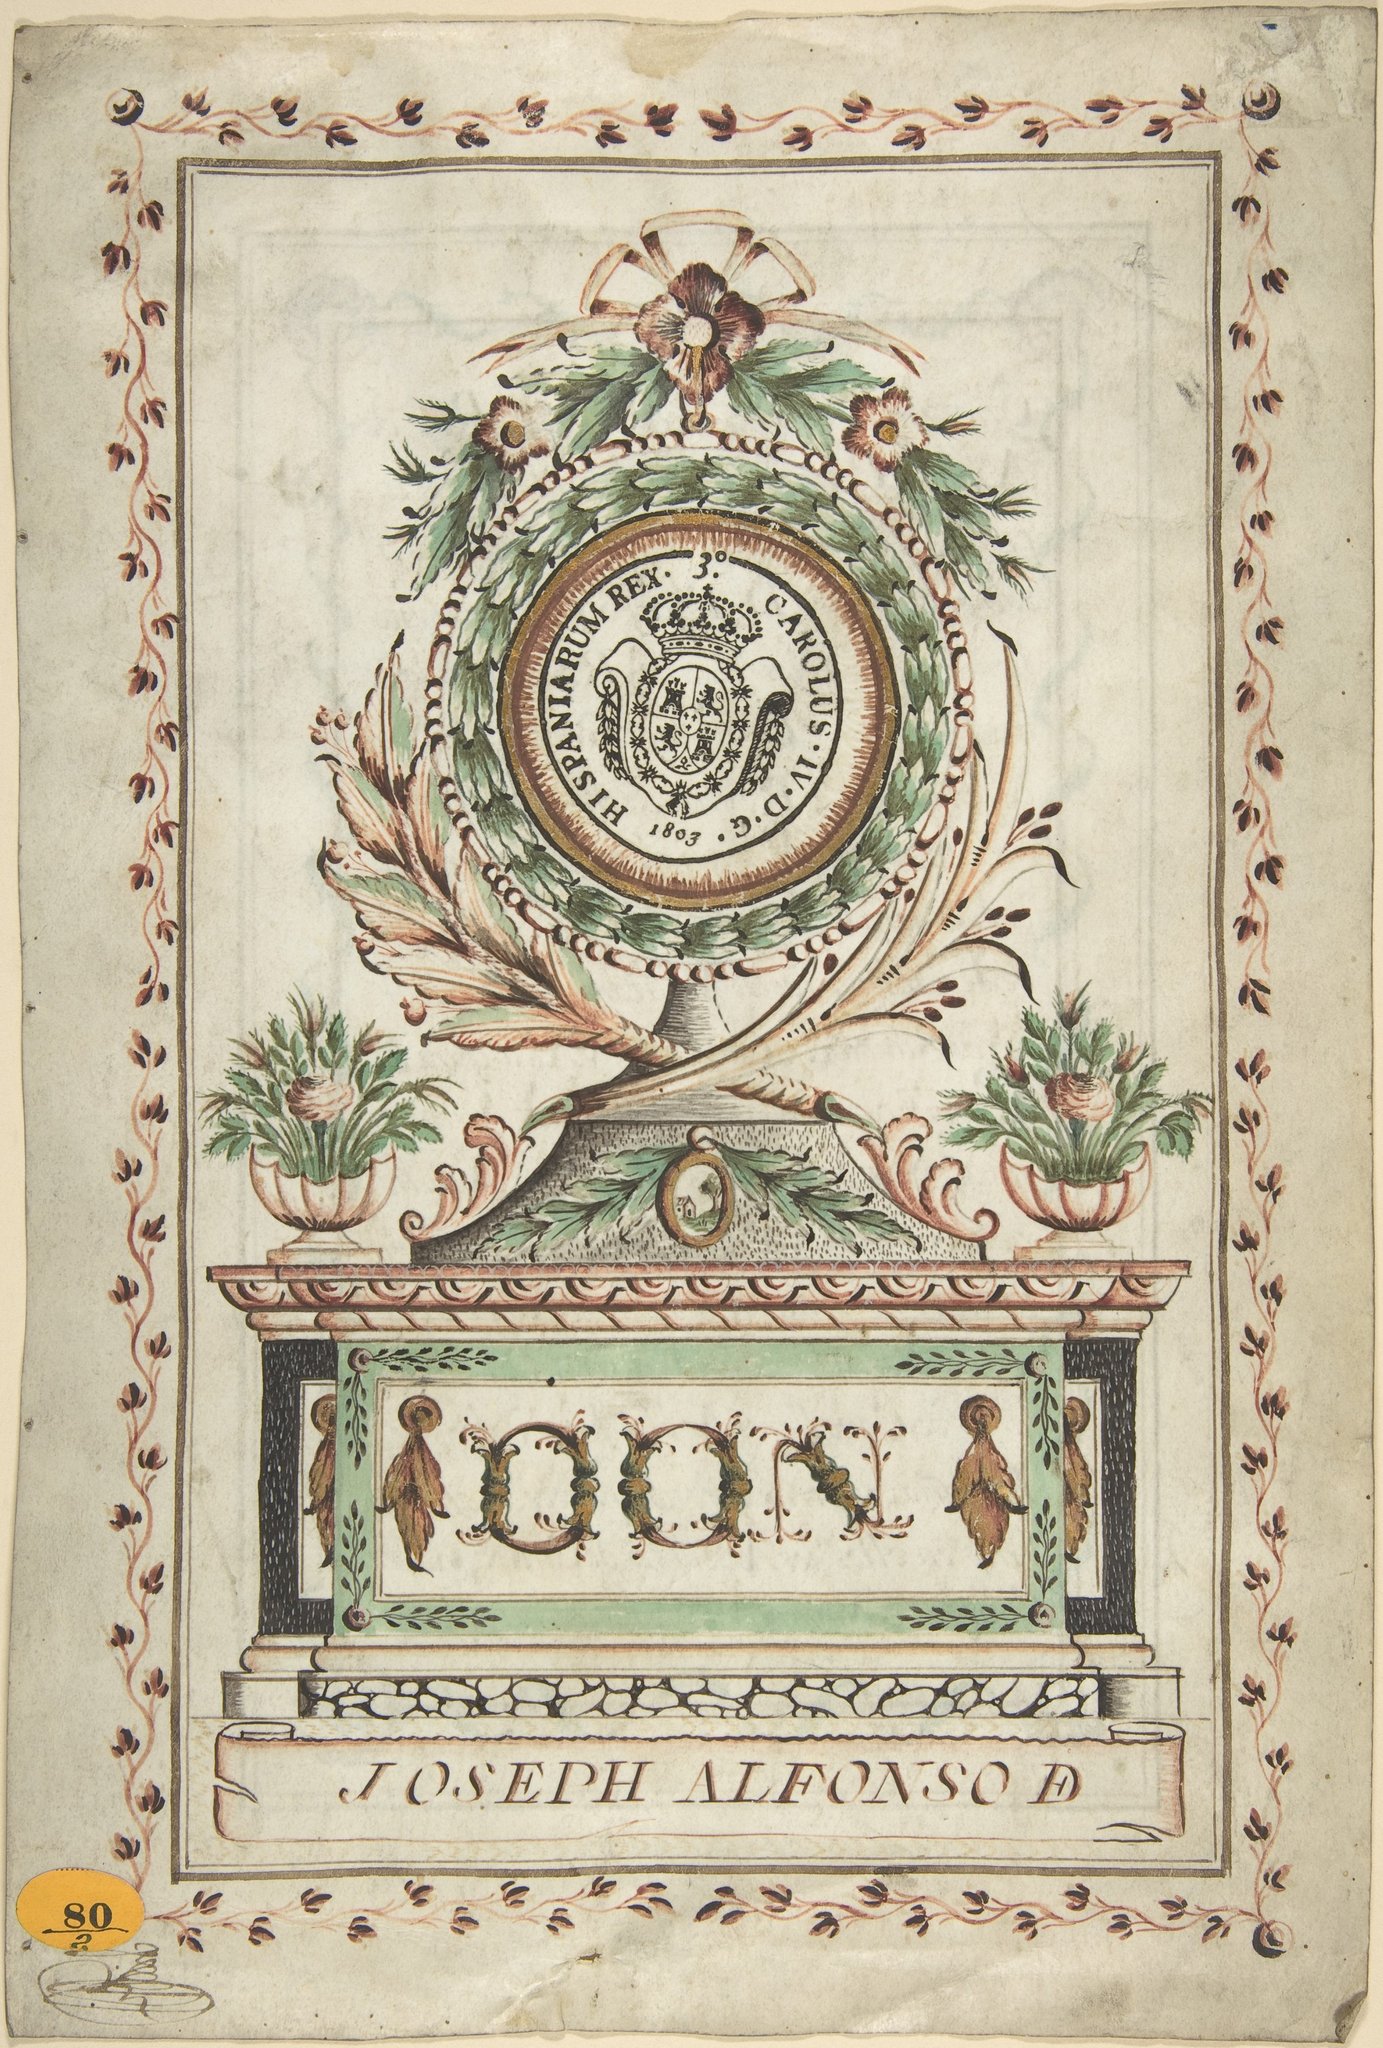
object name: drawing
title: Frontispiece with Vegetal Medallion and Latin Dedication surrounding a Coat of Arms (Recto); Page of Spanish Writing within Border (Verso)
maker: anonymous, spanish, 18th century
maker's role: artist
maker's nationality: spanish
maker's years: 1700-1800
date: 1701-1800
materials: paint, ink, parchment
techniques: brush, pen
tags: flowers,leaves,coat of arms